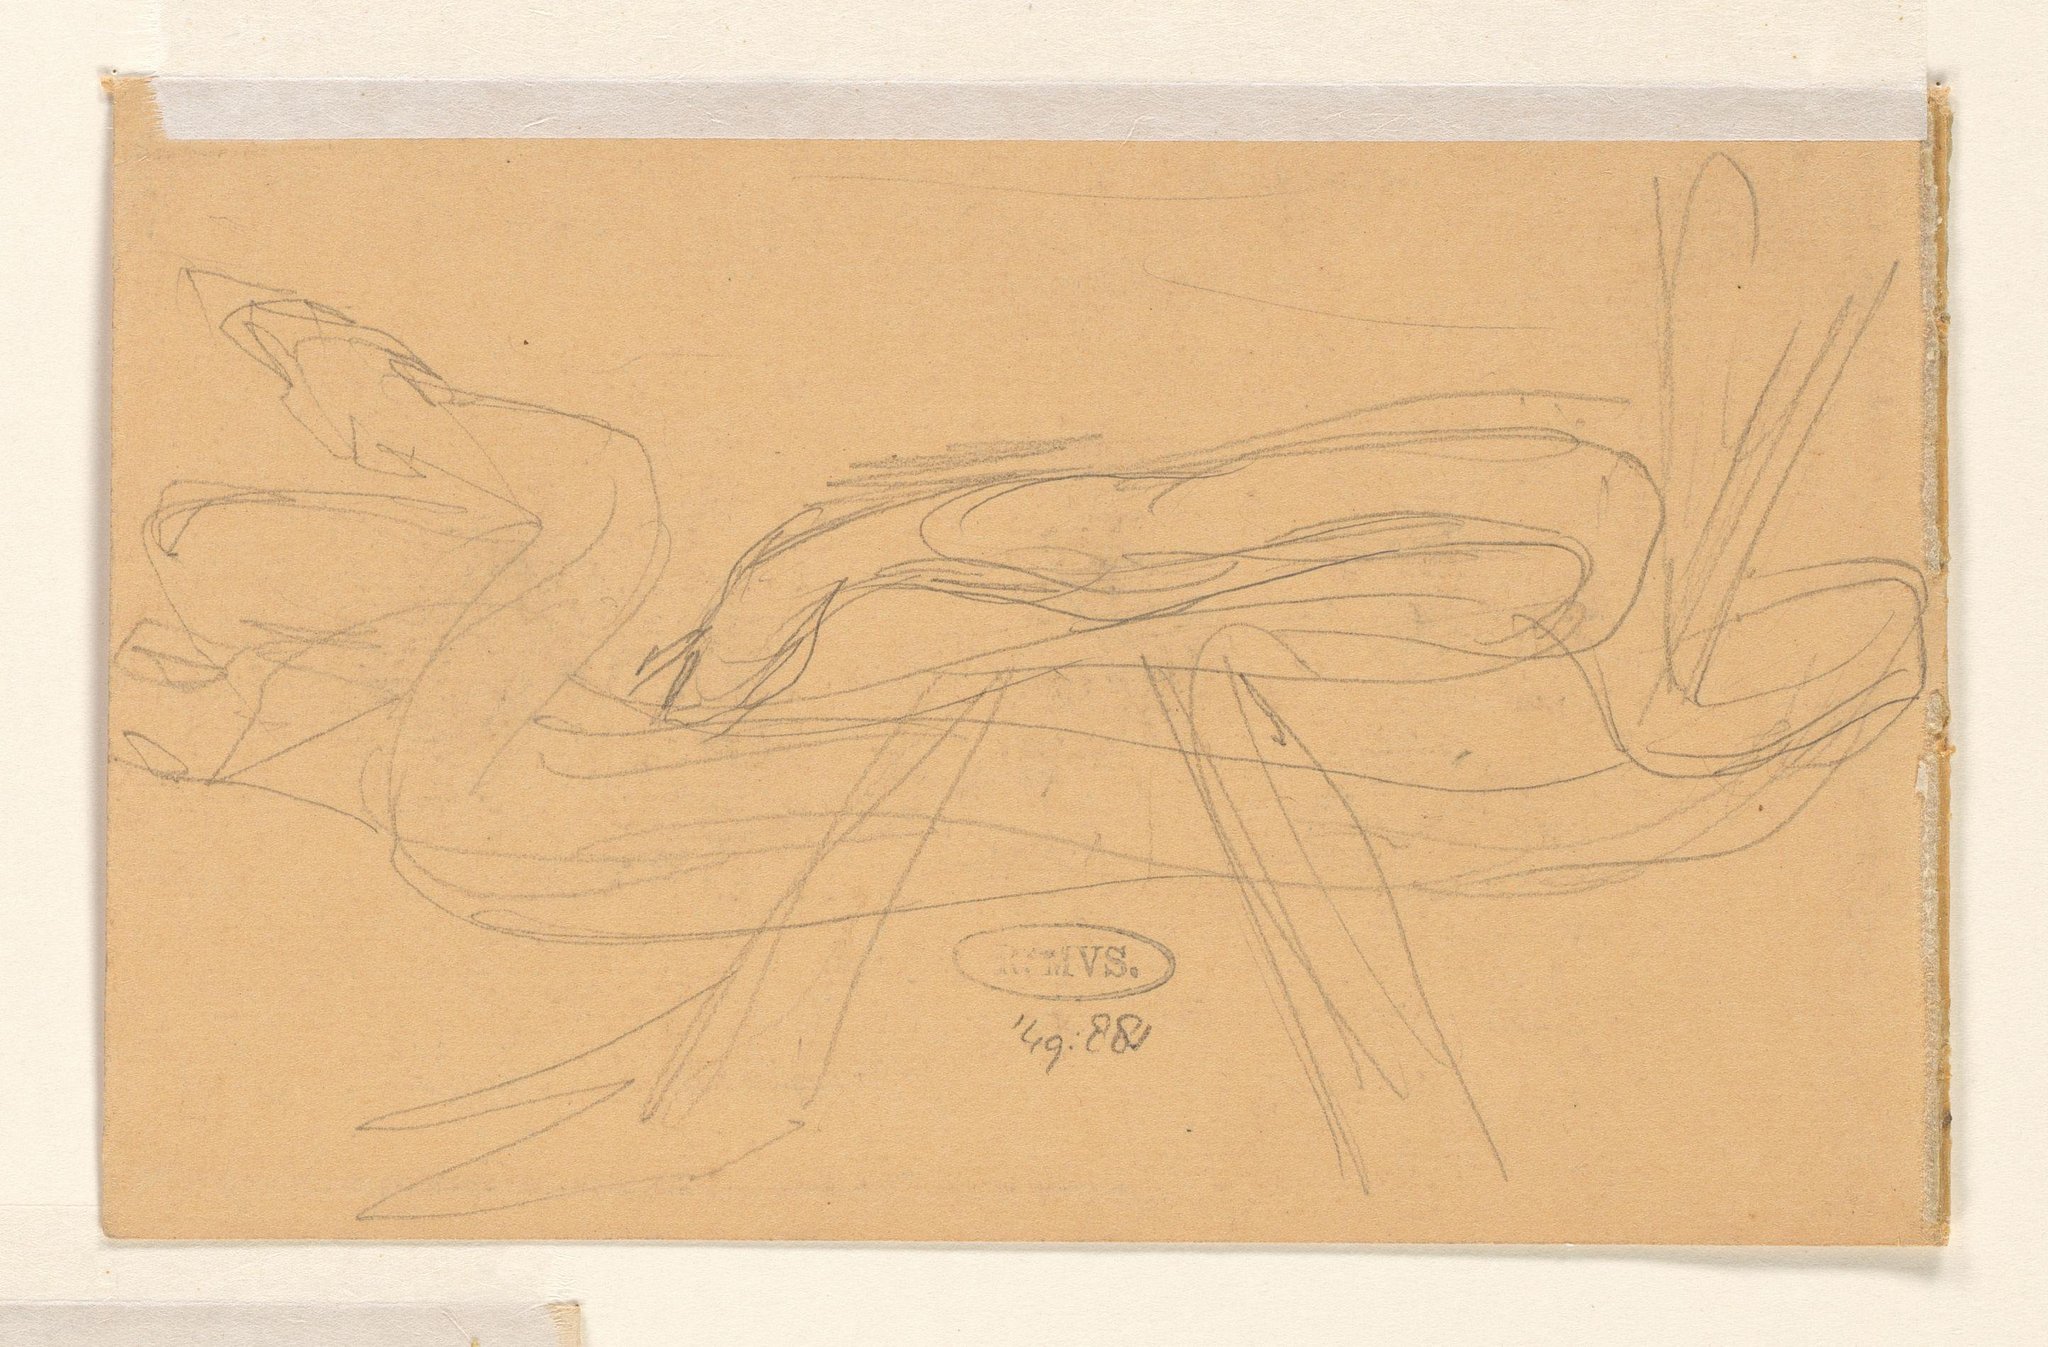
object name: drawing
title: Schetsblad met studie van slangen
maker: august allebé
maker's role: draughtsman, print maker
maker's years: 1838-1927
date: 1848-1927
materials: paper, pencil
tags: snakes